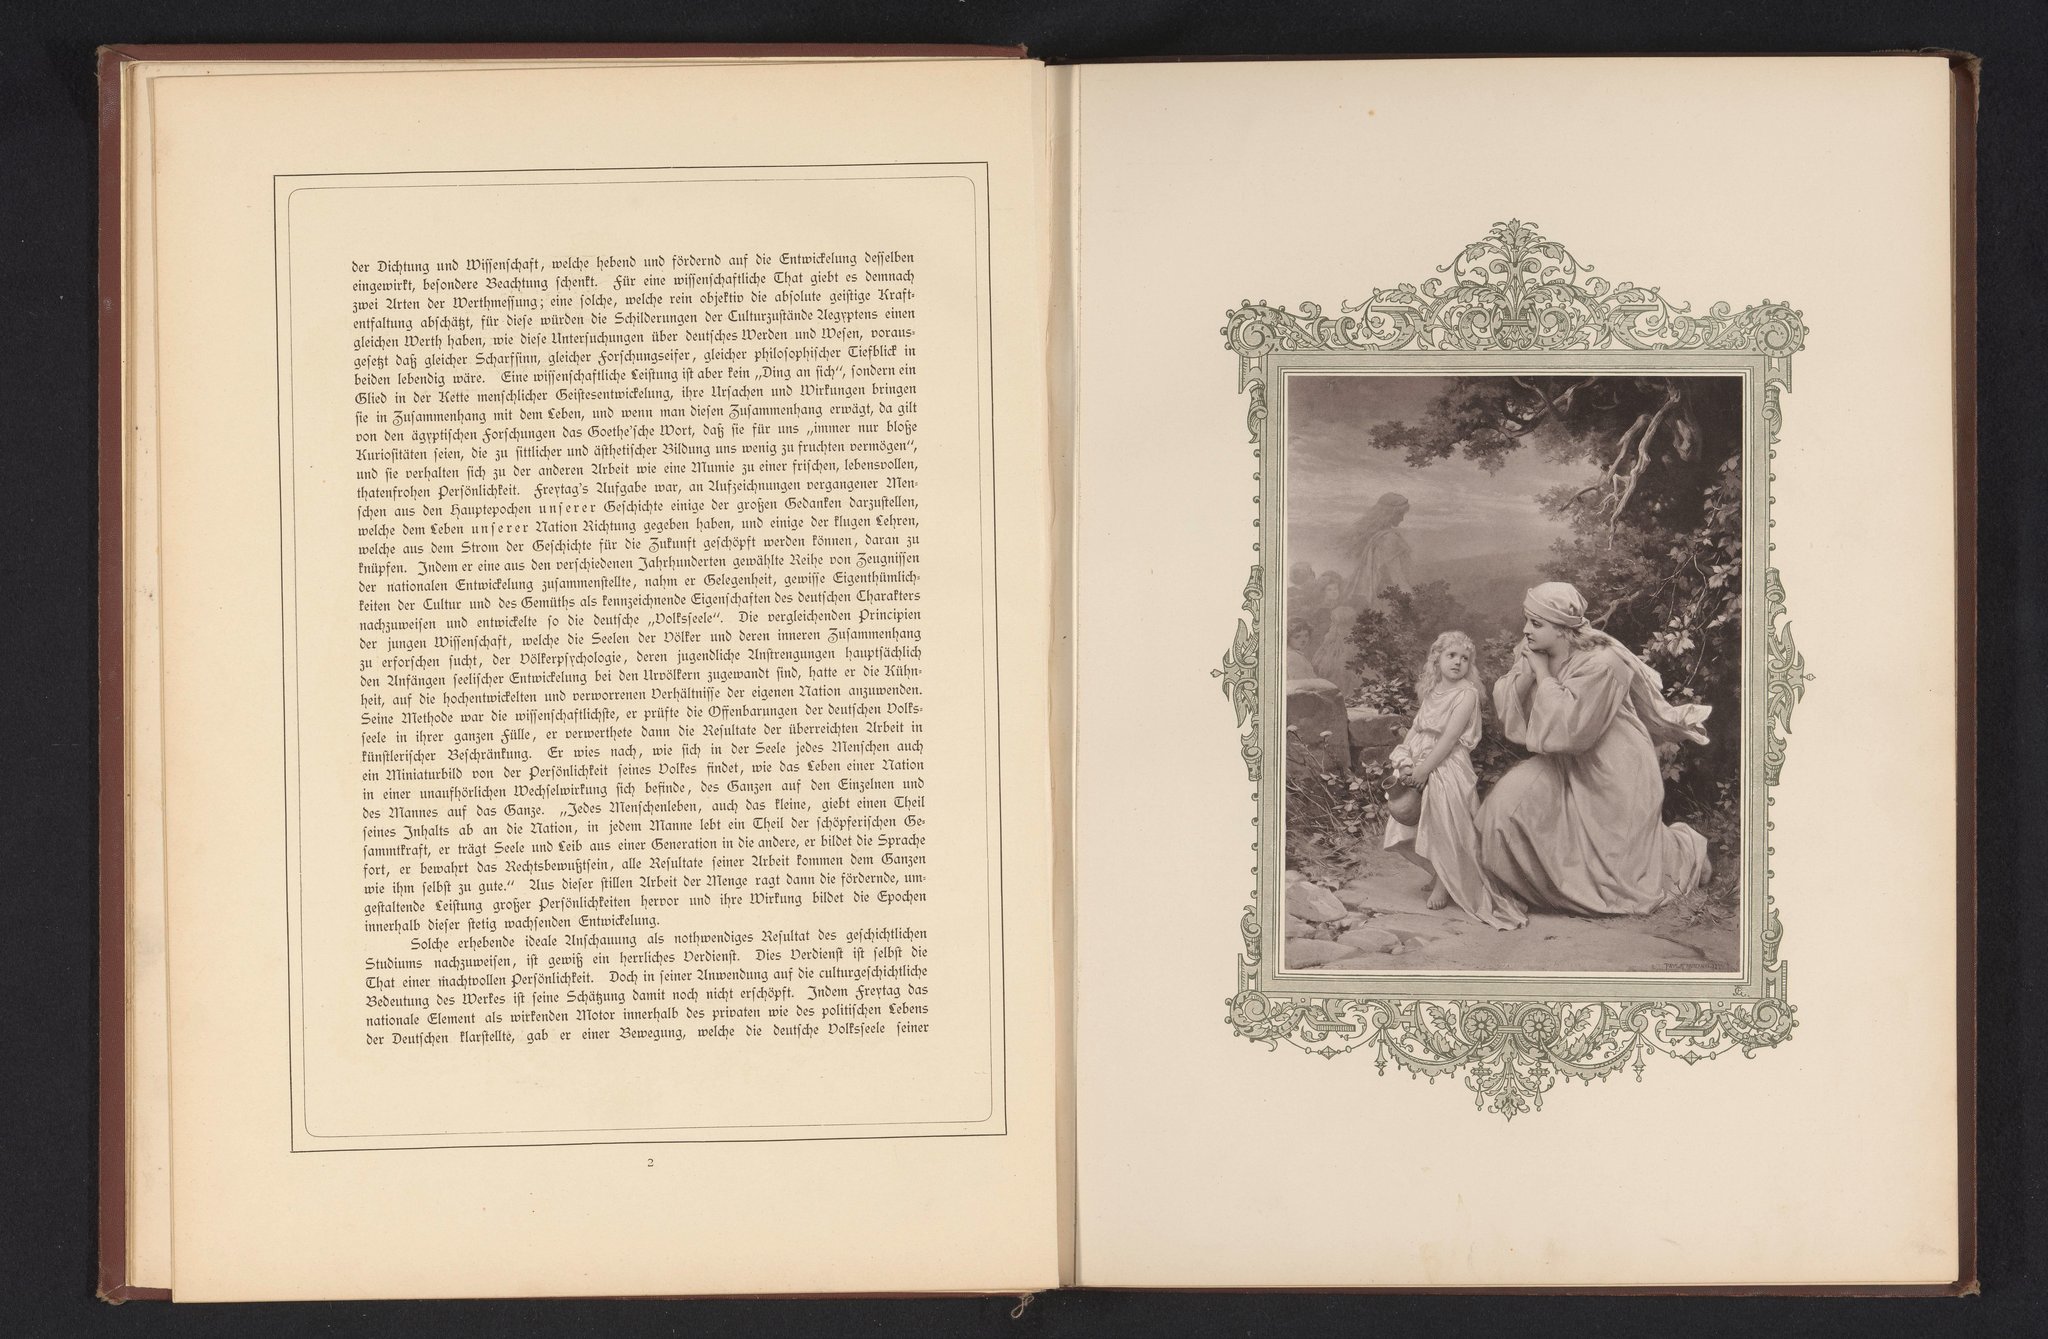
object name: page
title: Fotoreproductie van een schilderij voorstellende een kind met een kruik met daarachter een vrouw geknield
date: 1877-1882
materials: paper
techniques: photograph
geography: germany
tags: child, container of ceramics: jar, jug, pot, vase